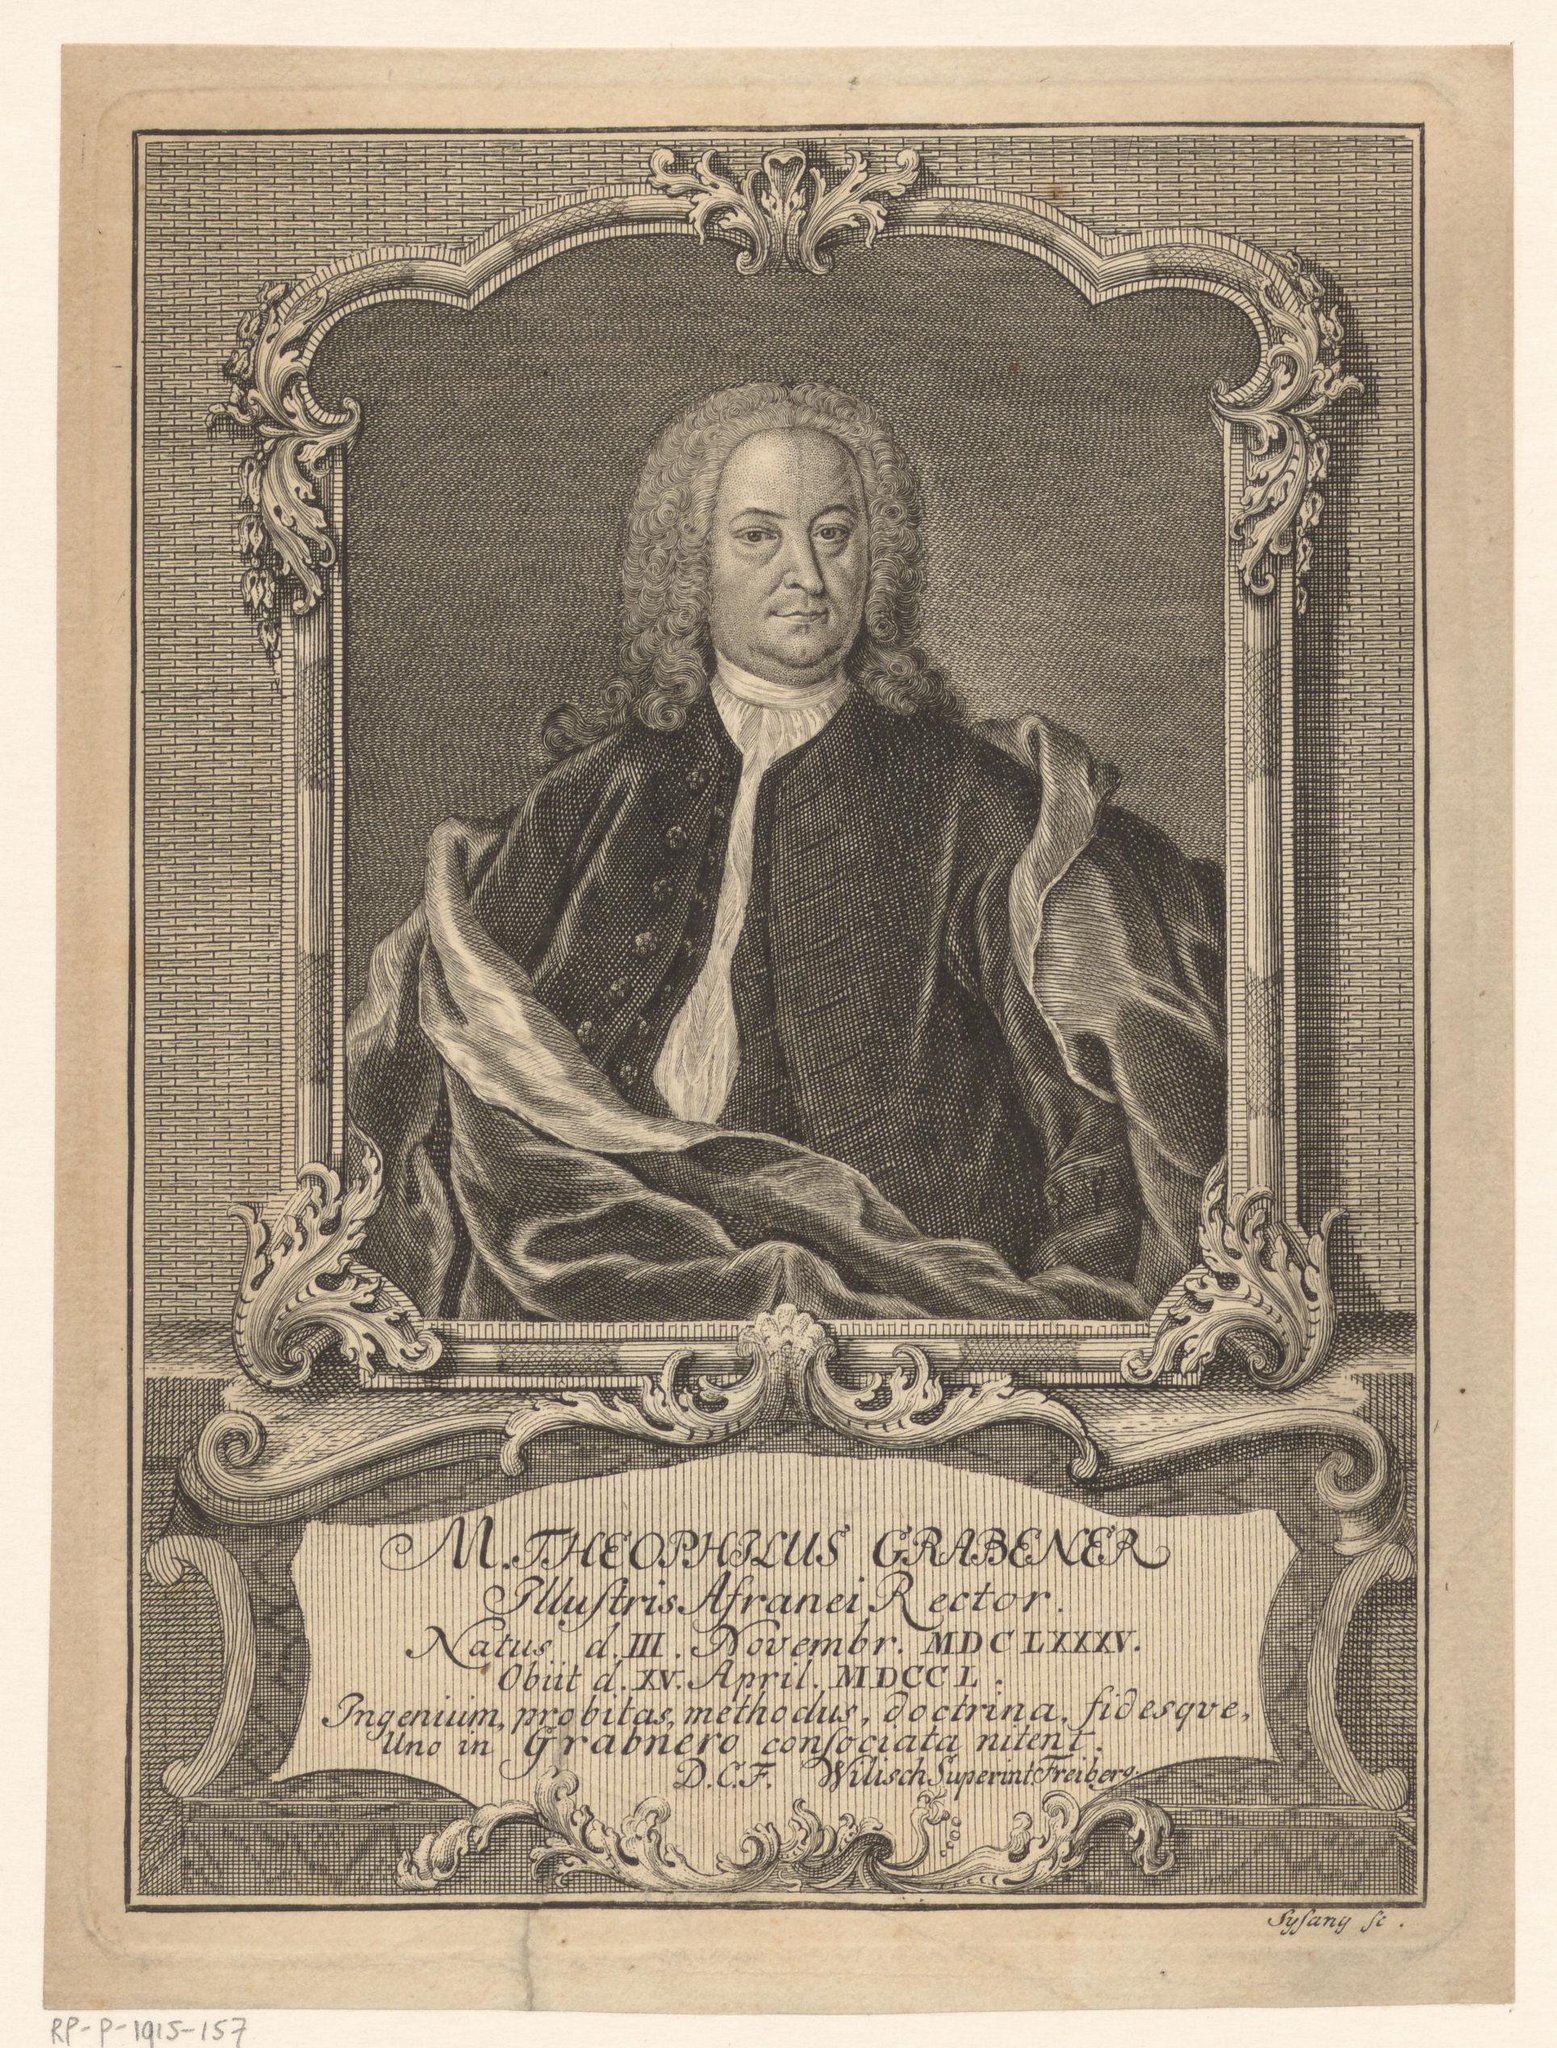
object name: print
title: Portret van Theophilus Grabener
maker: johann christoph sysang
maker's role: print maker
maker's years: 1703-1757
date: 1750-1757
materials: paper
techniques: engraving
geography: germany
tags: historical persons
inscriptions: collector's mark: Lugt 2228